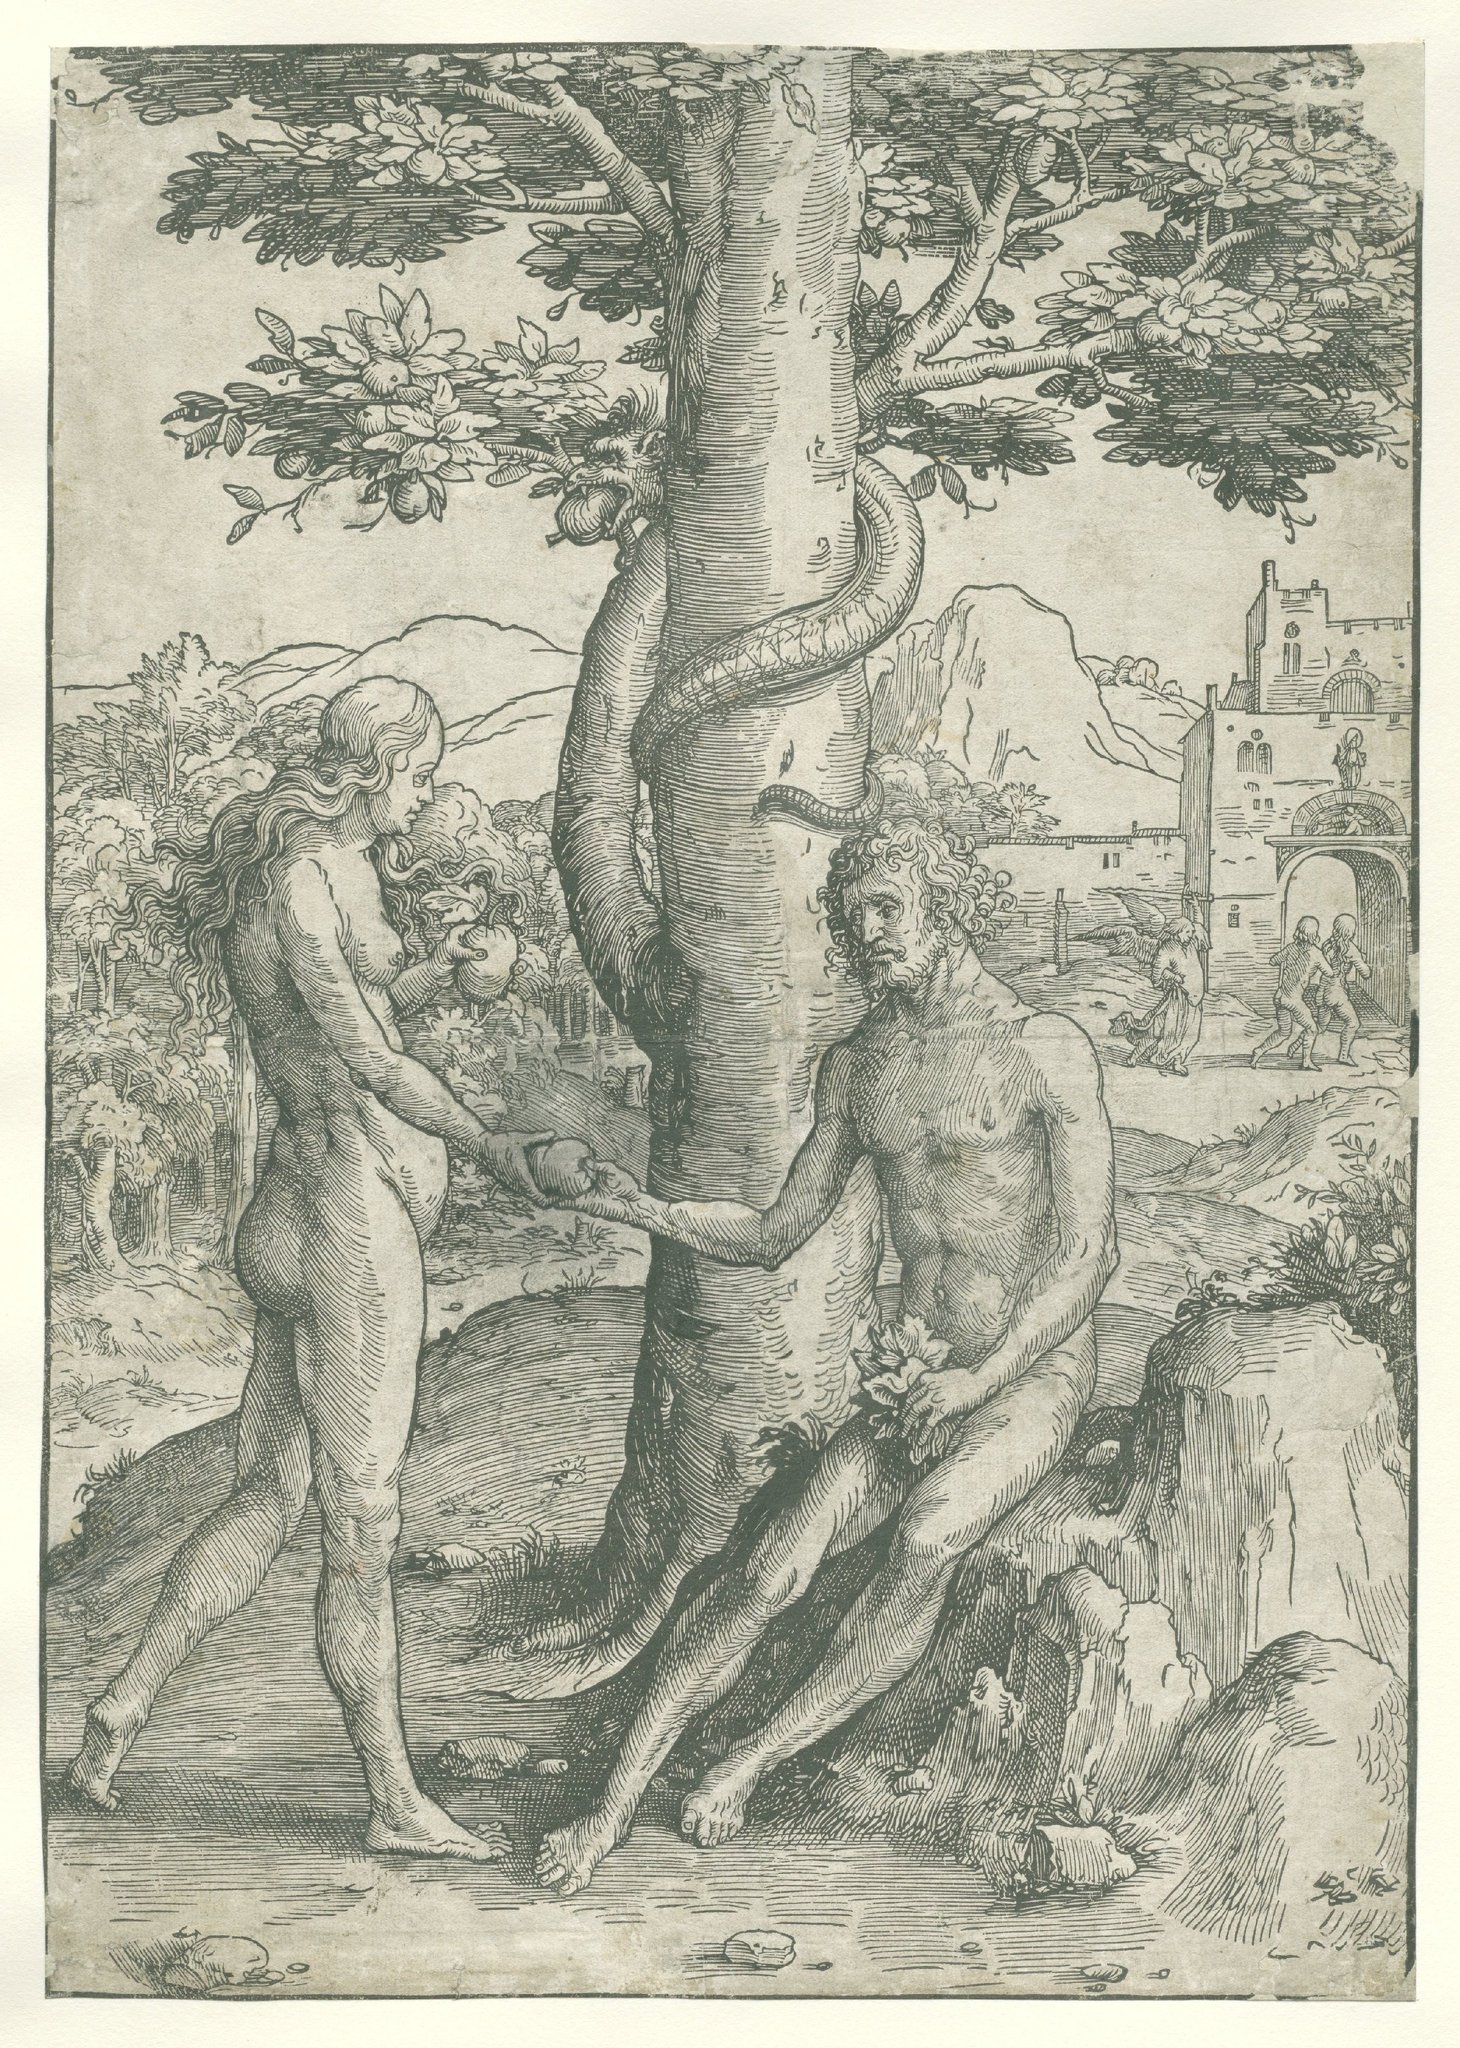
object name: print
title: De zondeval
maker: lucas van leyden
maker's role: draughtsman, painter, print maker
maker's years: 1494-1533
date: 1512-1516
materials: paper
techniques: woodcut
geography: low countries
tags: eve offers the fruit to adam, an angel chases adam and eve out of paradise with a (flaming) sword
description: Eva overhandigt Adam de verboden vrucht. Rechts op de achtergrond de verdrijving uit het Paradijs.